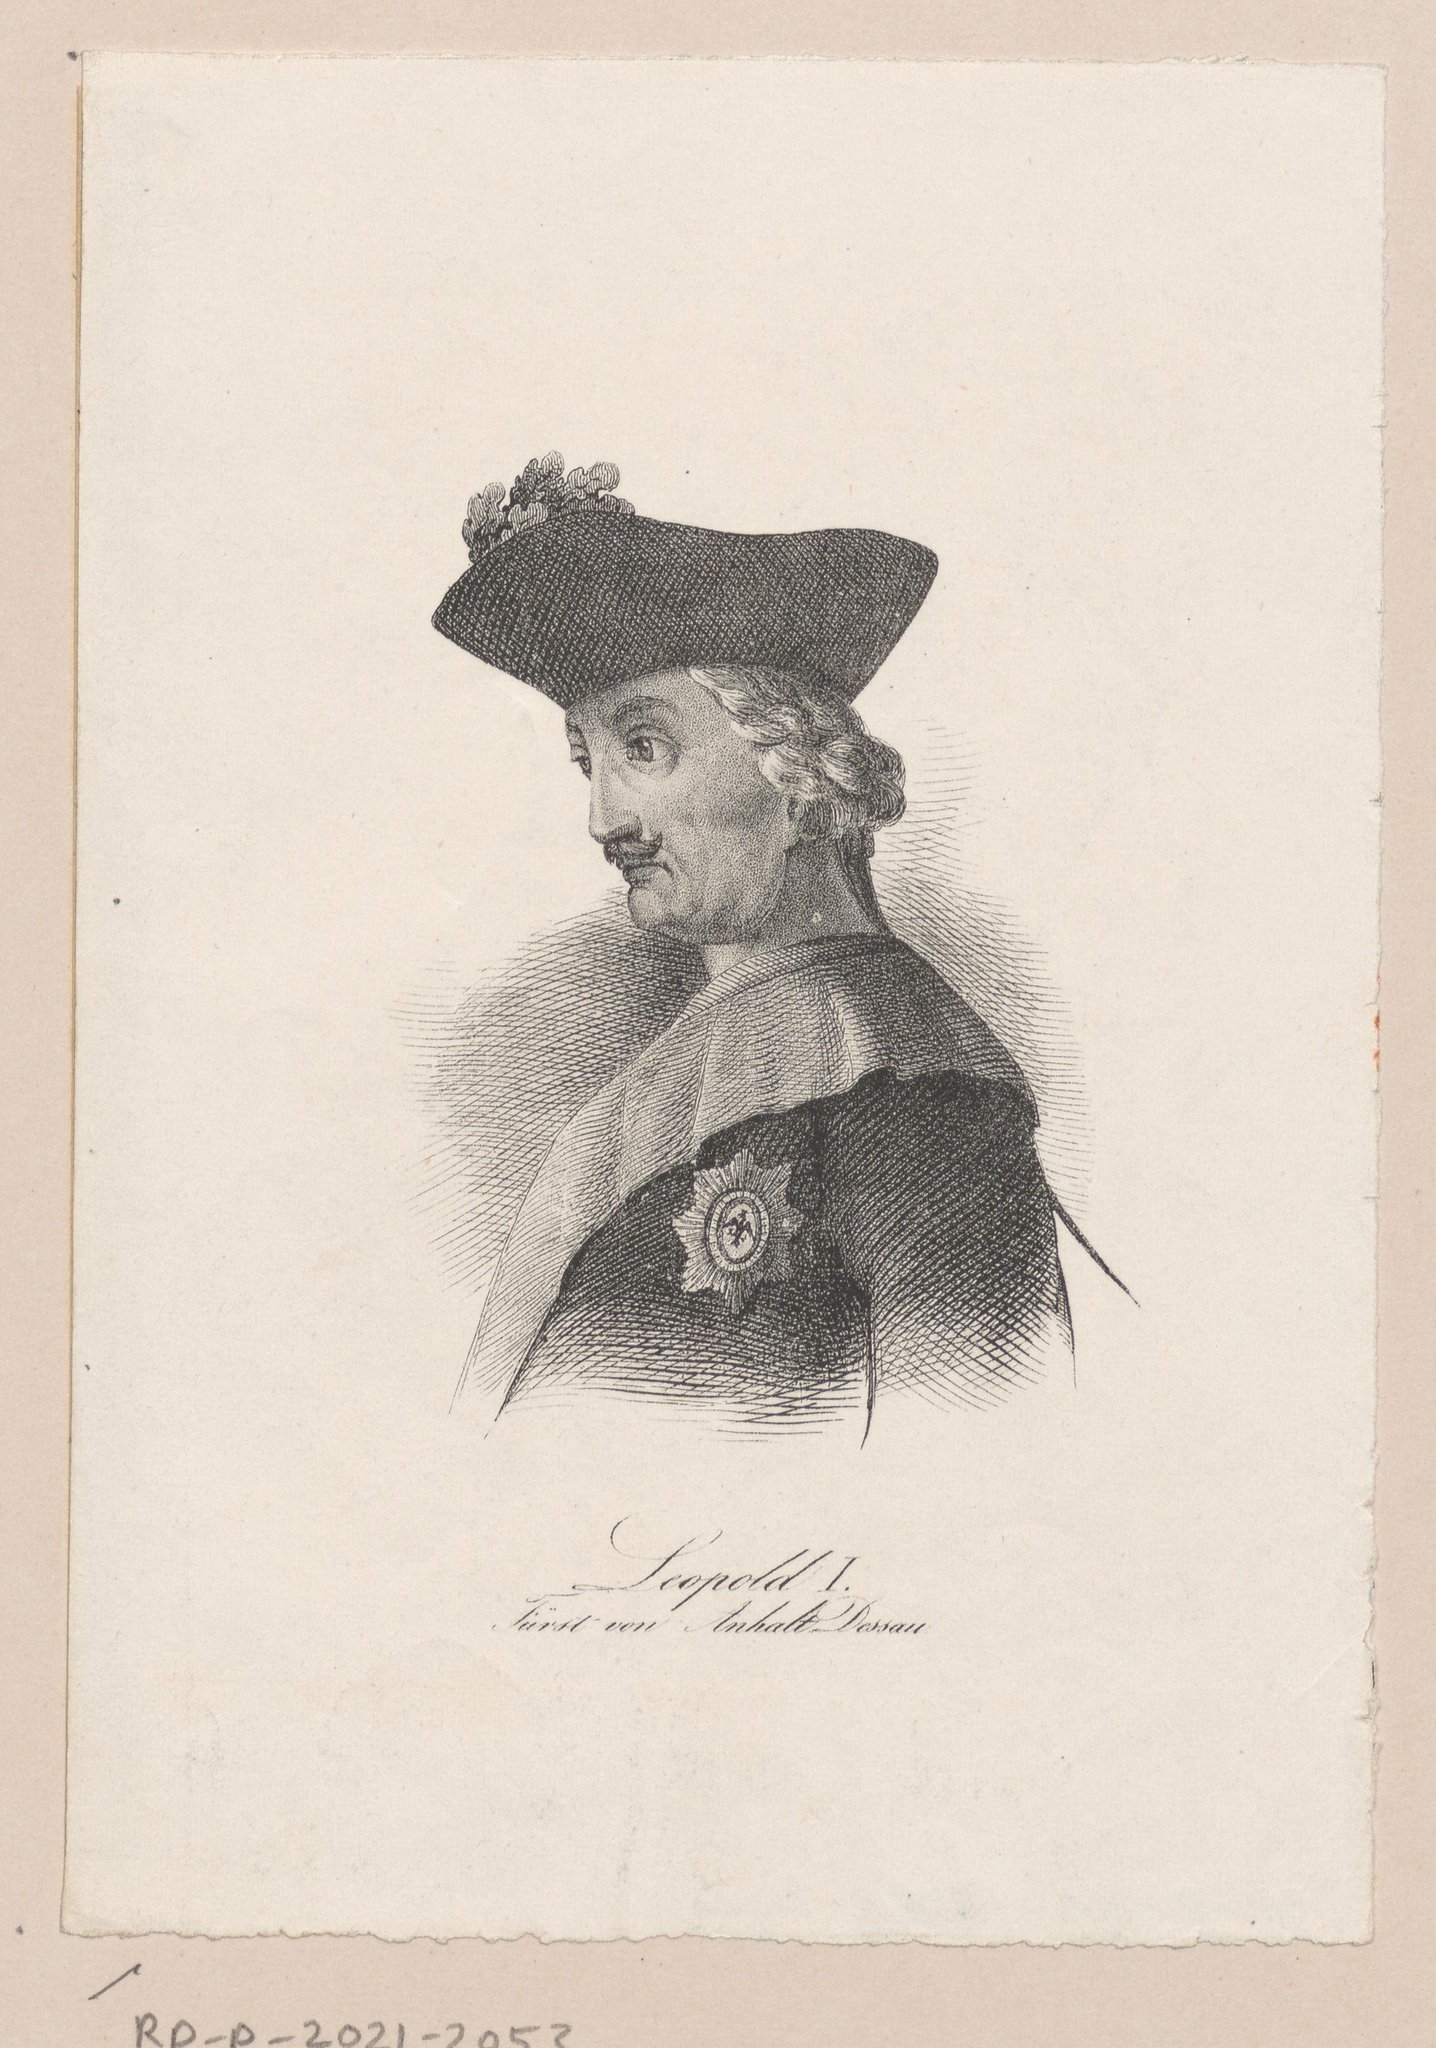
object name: book illustration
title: Portret van Leopold I van Anhalt-Dessau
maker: Anonymous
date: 1840-1843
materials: paper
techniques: lithograph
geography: germany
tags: historical persons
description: Prent waarschijnlijk uit: Förster, Friedrich Christoph. Leben und Thaten Friedrich's des Grossen (...). Meissen: F.W. Goedsche, 1840, dl. 1. Of uit de editie uitgegeven door B.G. Teubner in 1843.